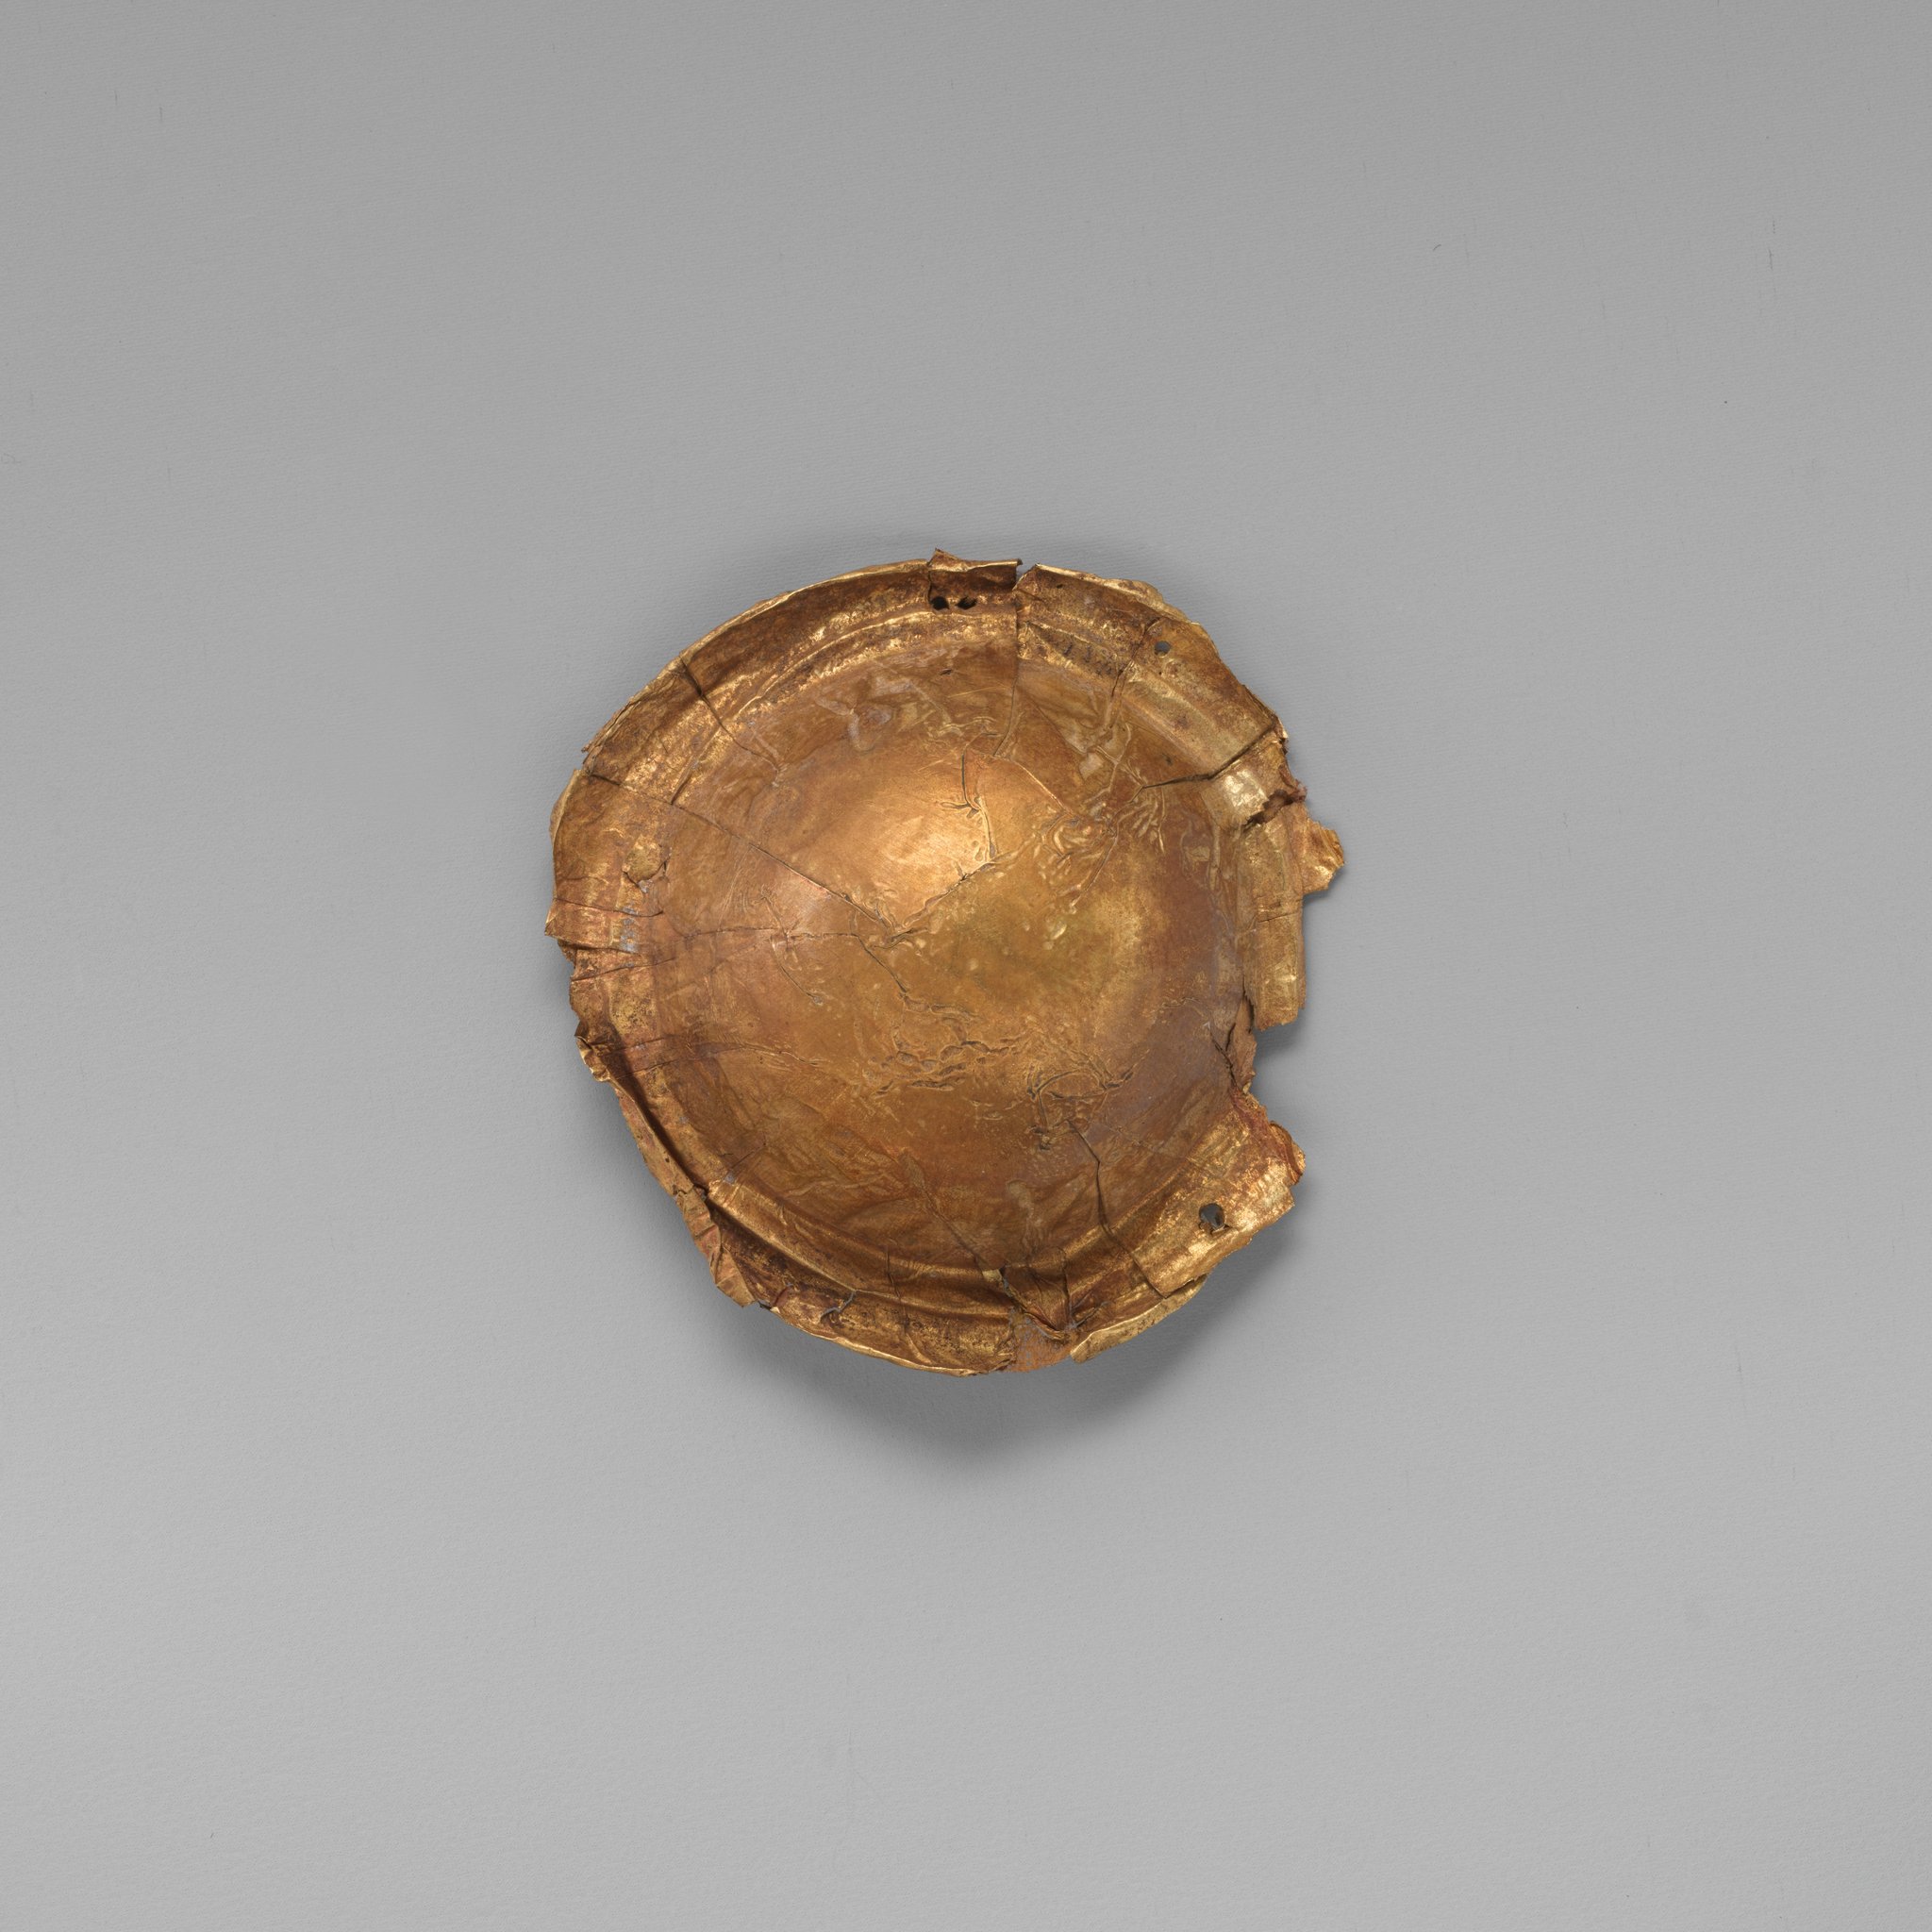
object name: roundel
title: Gold roundel of bulbous form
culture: cypriot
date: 1600-1050 BCE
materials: gold